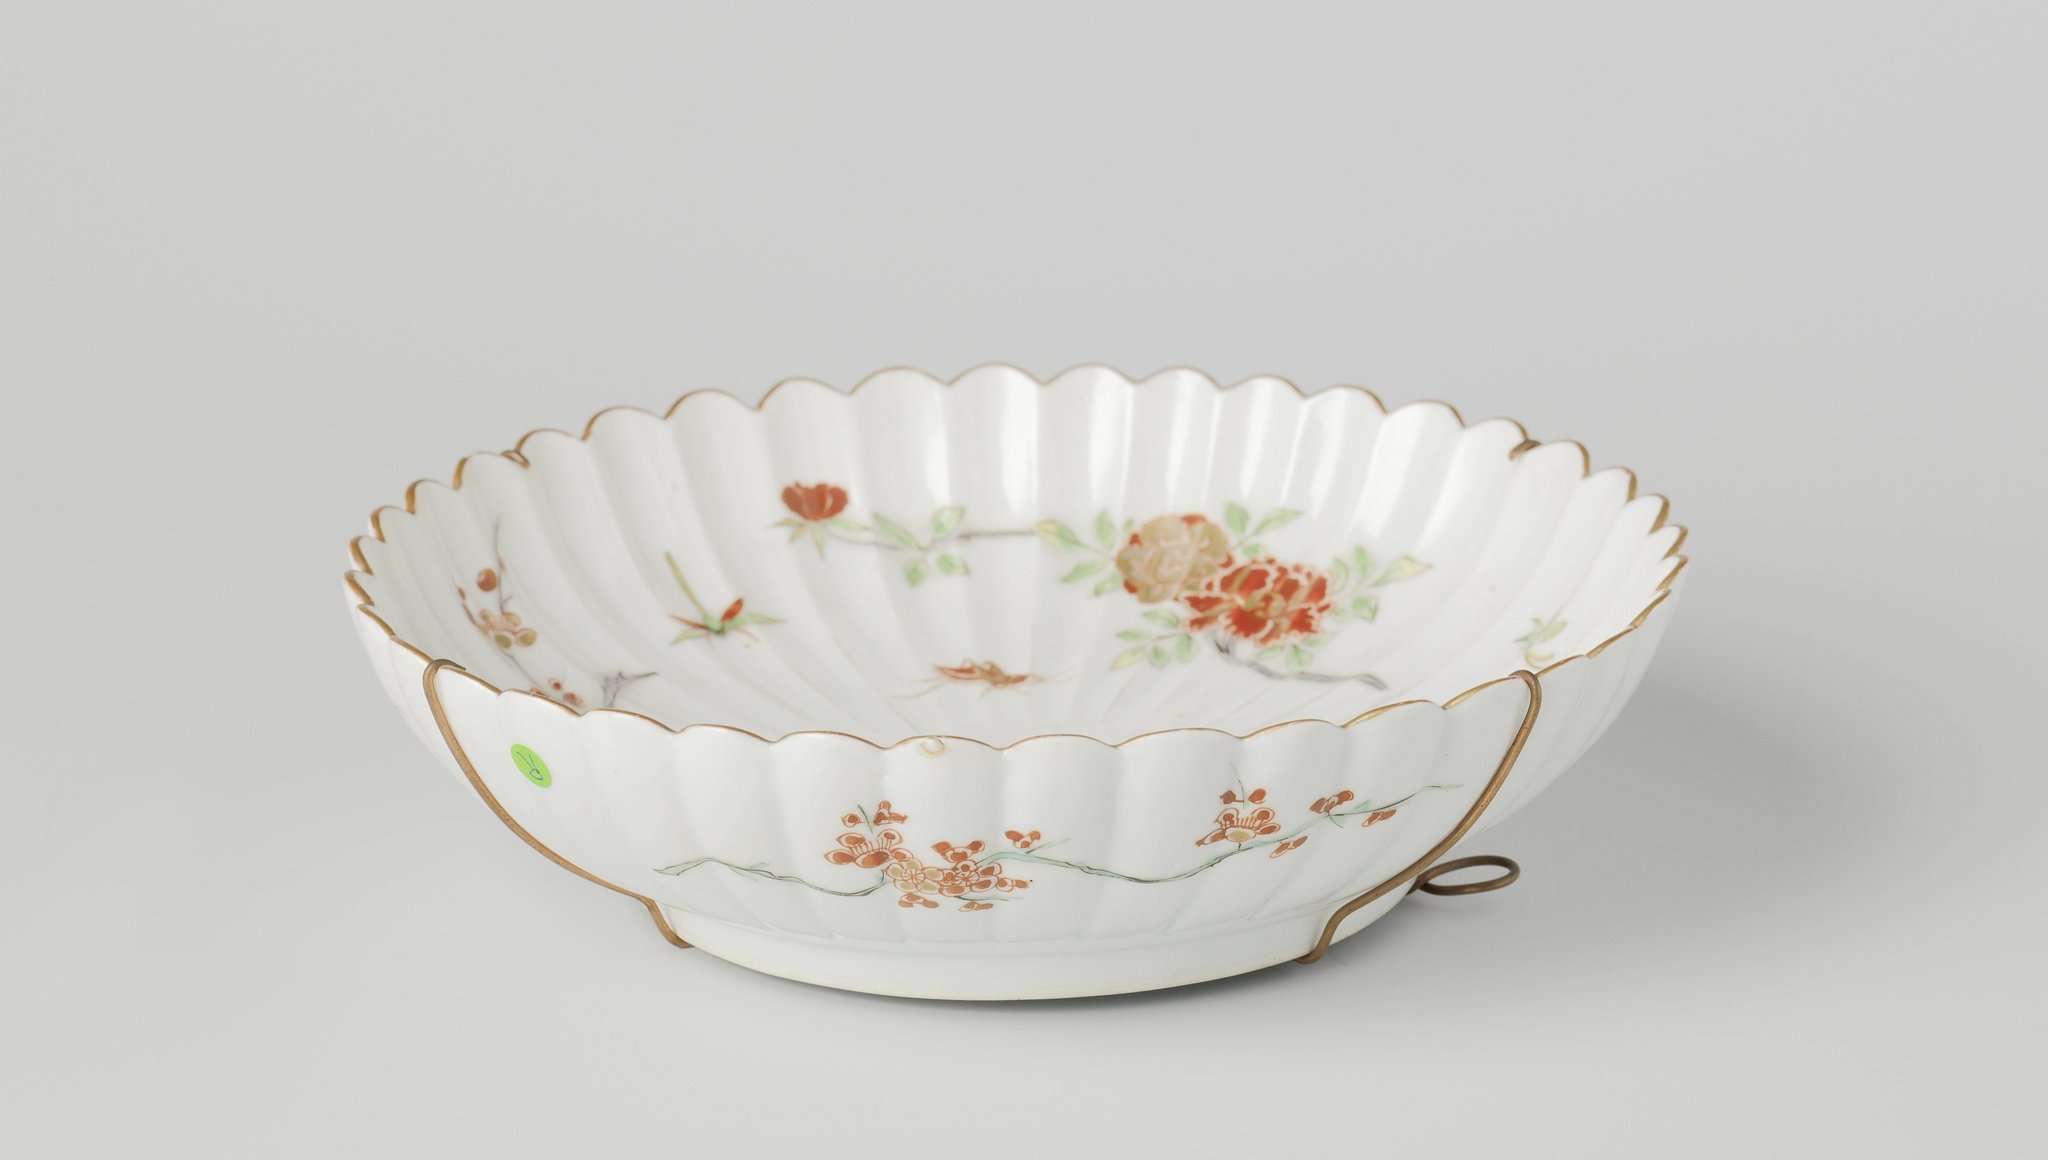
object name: dish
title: Suacer-dish with fluted sides and insects, peony and prunus sprays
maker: Anonymous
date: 1720-1740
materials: cobalt, glaze, gold, metal, paint, porcelain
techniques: firing, gilding, turning, vitrification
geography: japan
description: AK-NM-6378 Twee schalen • Japans porselein - beschilderd in Nederland • Onderdeel van Royers porseleincollectie Het porselein is Japans. De vorm, maar dan met een Japans decor, komt in verschillende andere collecties voor [Lang 1983, no. 63; Eastern ceramics…Reitlinger 1981, nr. 212]. Maar deze bloemtakken zijn stijver dan men van een Japanse schilder zou verwachten en precies zulke ranken zijn nog niet gevonden in ‘echt’ Japans porselein. De kleur groen is ook opmerkelijk. Het is geen tint groen die men in Japans porselein zou verwachten, maar wél in Chinees famille verte. Hoewel het onderscheid tussen Japanse en Europese beschilderingen soms, zoals hier ook, moeilijk vast te stellen is, zijn dit toch goed argumenten voor de veronderstelling dat de schalen in Nederland zijn gedecoreerd. Bronnen: Eastern ceramics and other works of art from the collection of Gerald Reitlinger, Oxford, 1981. Gordon Lang, The wrestling boys: an exhibition of Chinese and Japanese ceramics from the 16th to the 18th century in the collection at Burghley House, N.pl., 1983.